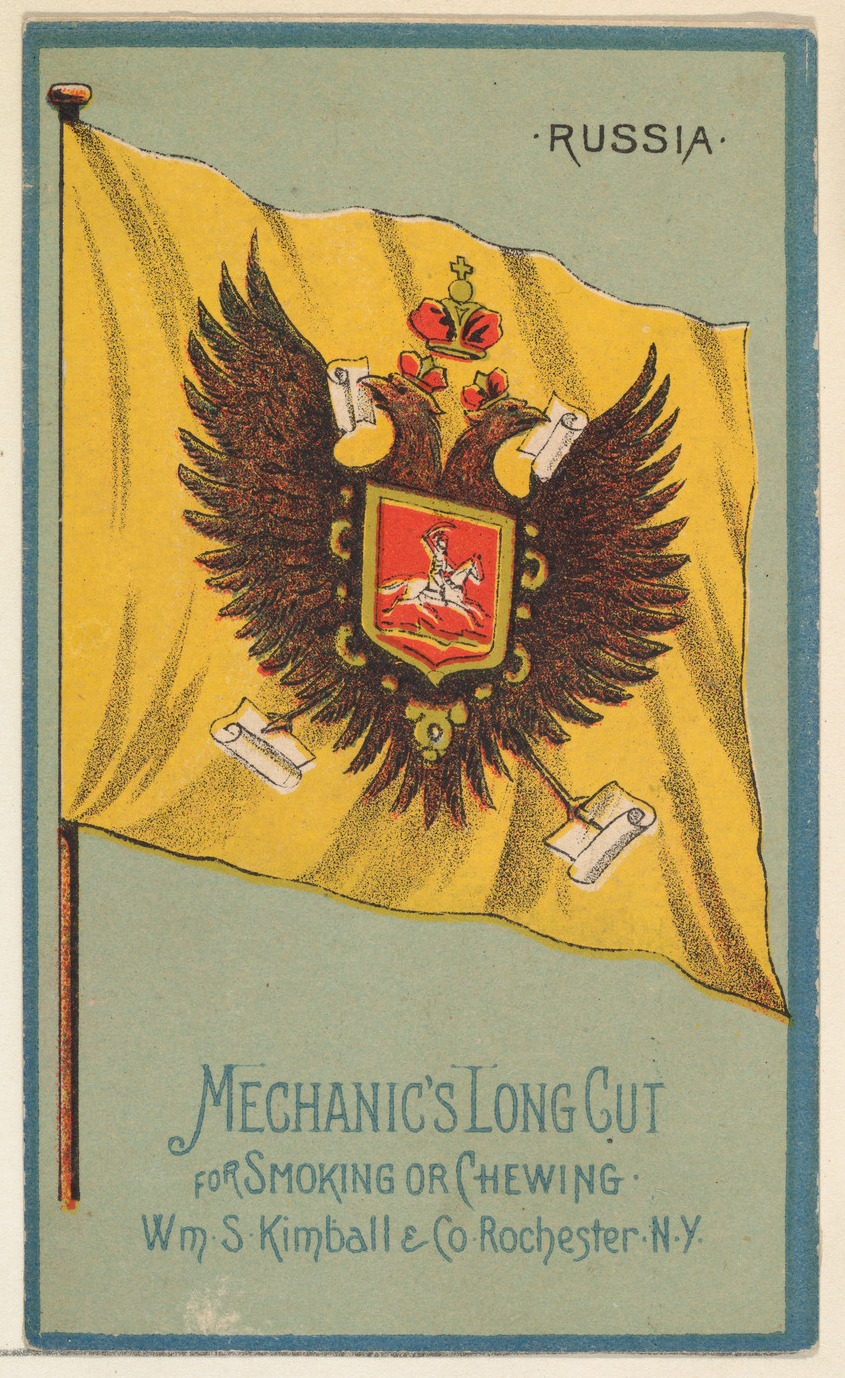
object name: print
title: Russia, from the National Flags series (N195) issued by Wm. S. Kimball & Co.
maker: william s. kimball & company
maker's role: publisher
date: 1891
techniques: color lithograph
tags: coat of arms,flags